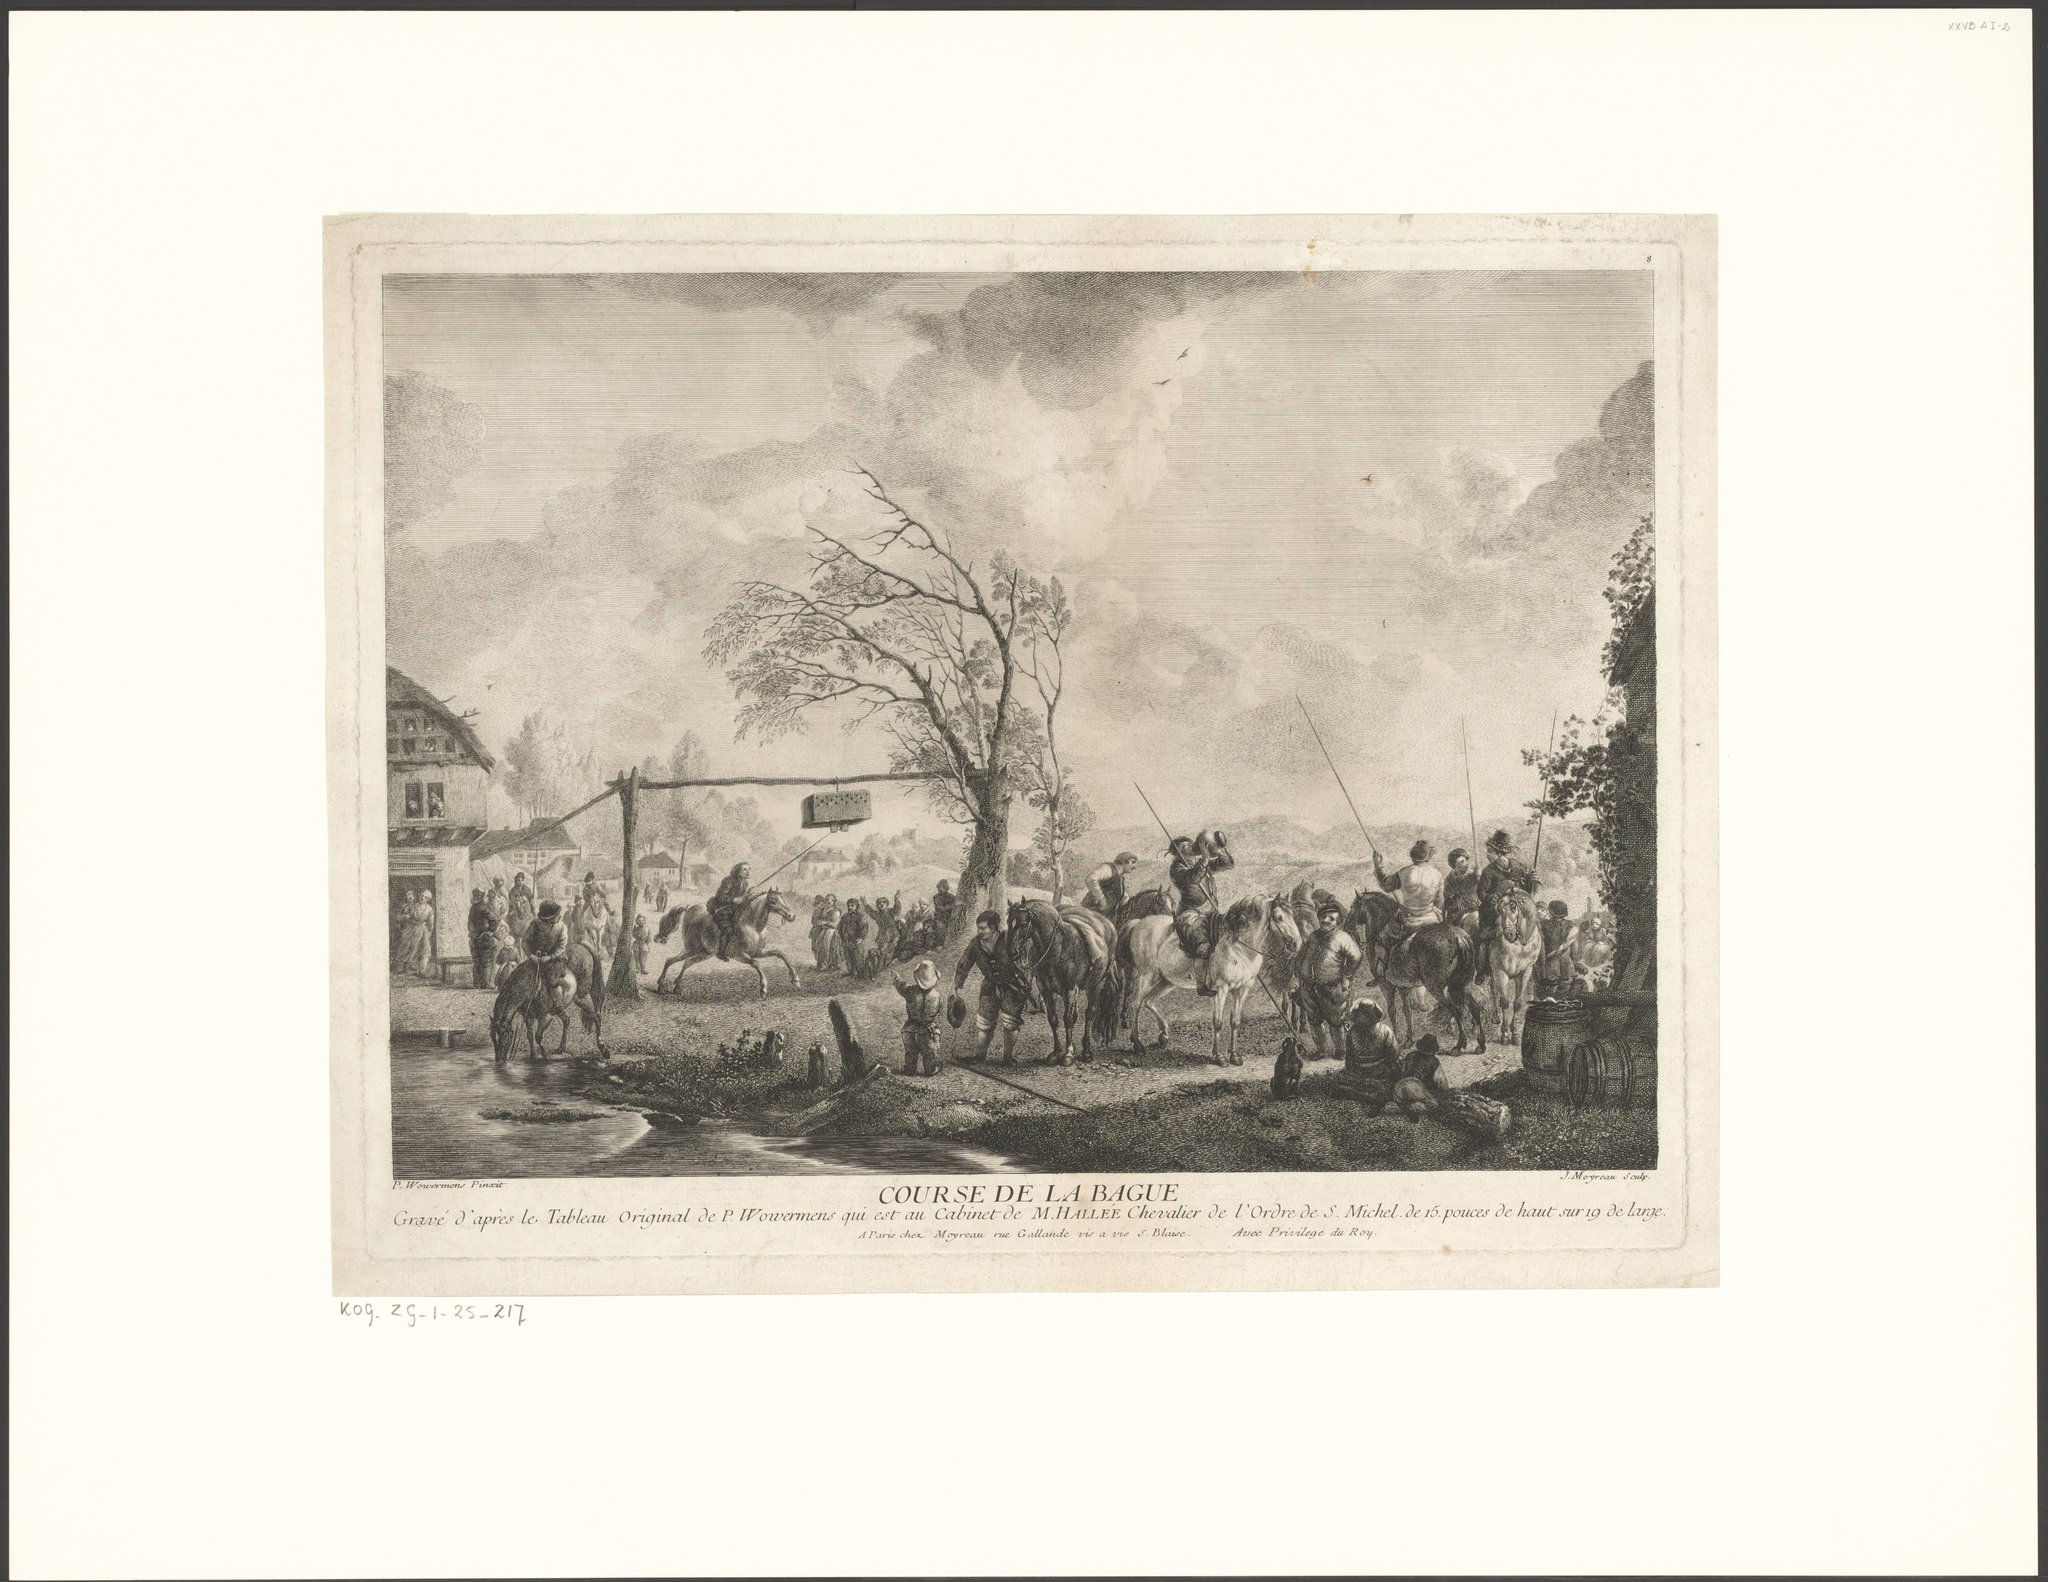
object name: print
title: Course de la Bague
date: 1733-1734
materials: paper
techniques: engraving, etching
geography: paris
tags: tilting at the ring (~ games of skill)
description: Bovenaan genummerd: 8. Onderwerpsrubrieken binnen de Atlas Zeden en Gewoonten: Zeden en Gewoonten in Engeren Zin, Spel en vermaak, Oud-Hollandsch volksspel, Ringsteken.